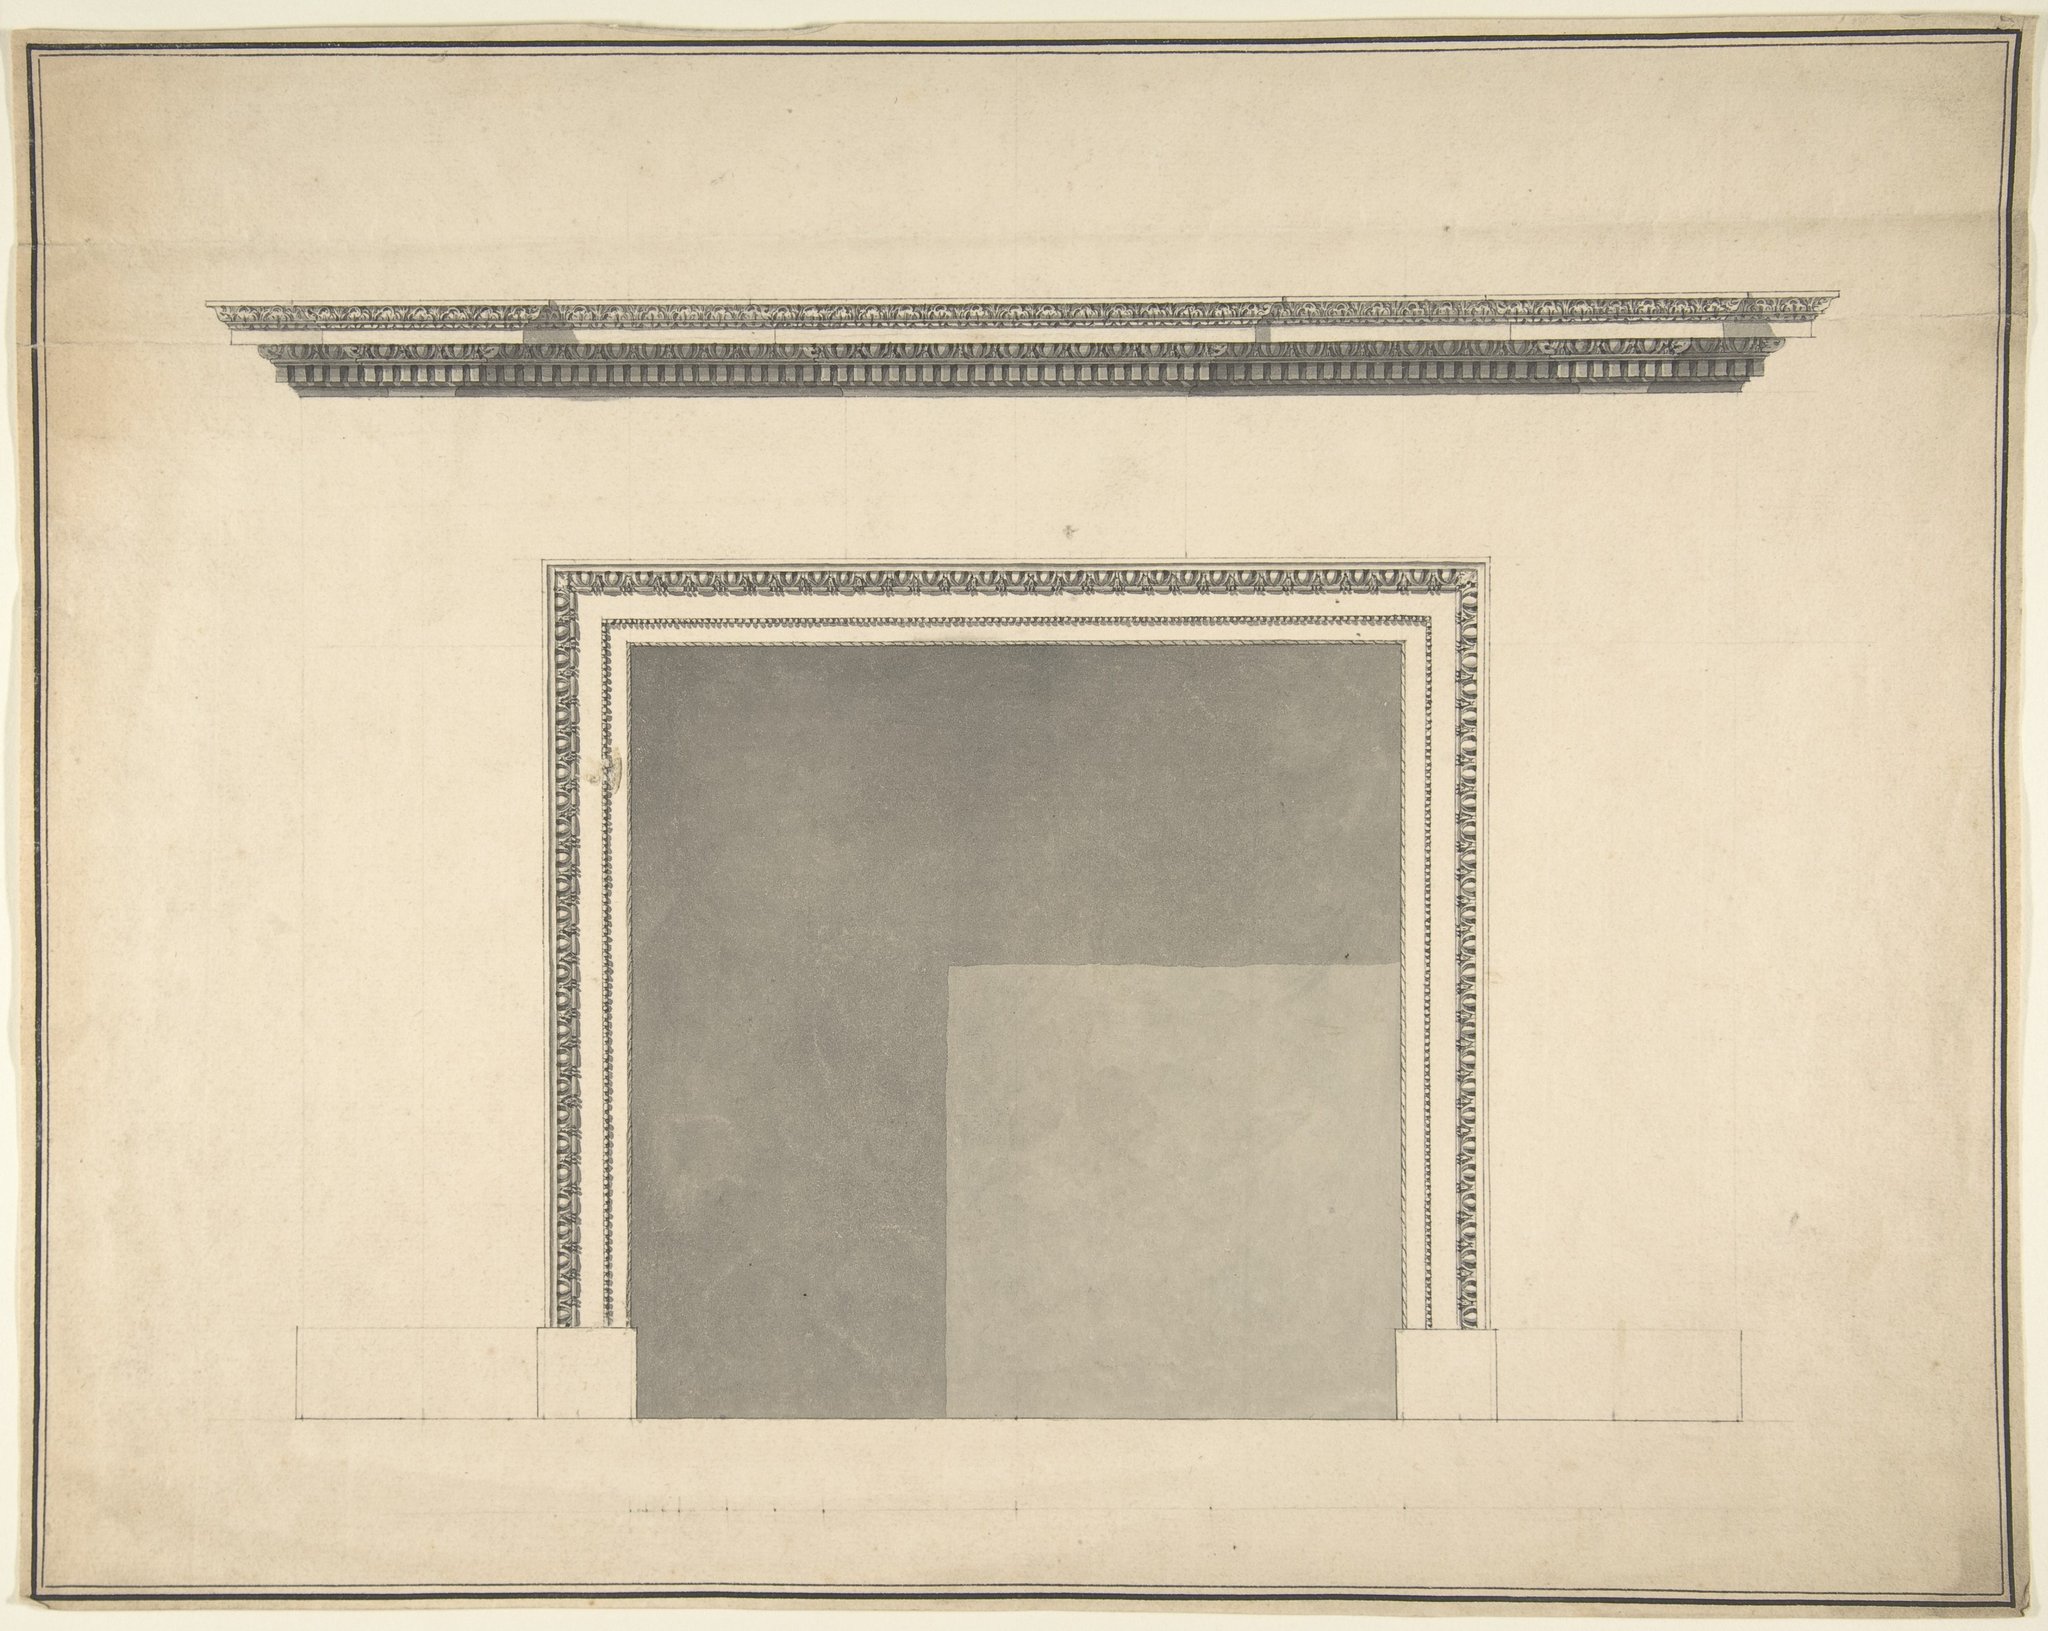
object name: drawing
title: Design for a Chimneypiece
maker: sir william chambers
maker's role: artist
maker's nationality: british, born sweden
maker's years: 1723-1796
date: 1740-1800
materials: ink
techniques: brush, pen, wash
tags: fireplaces